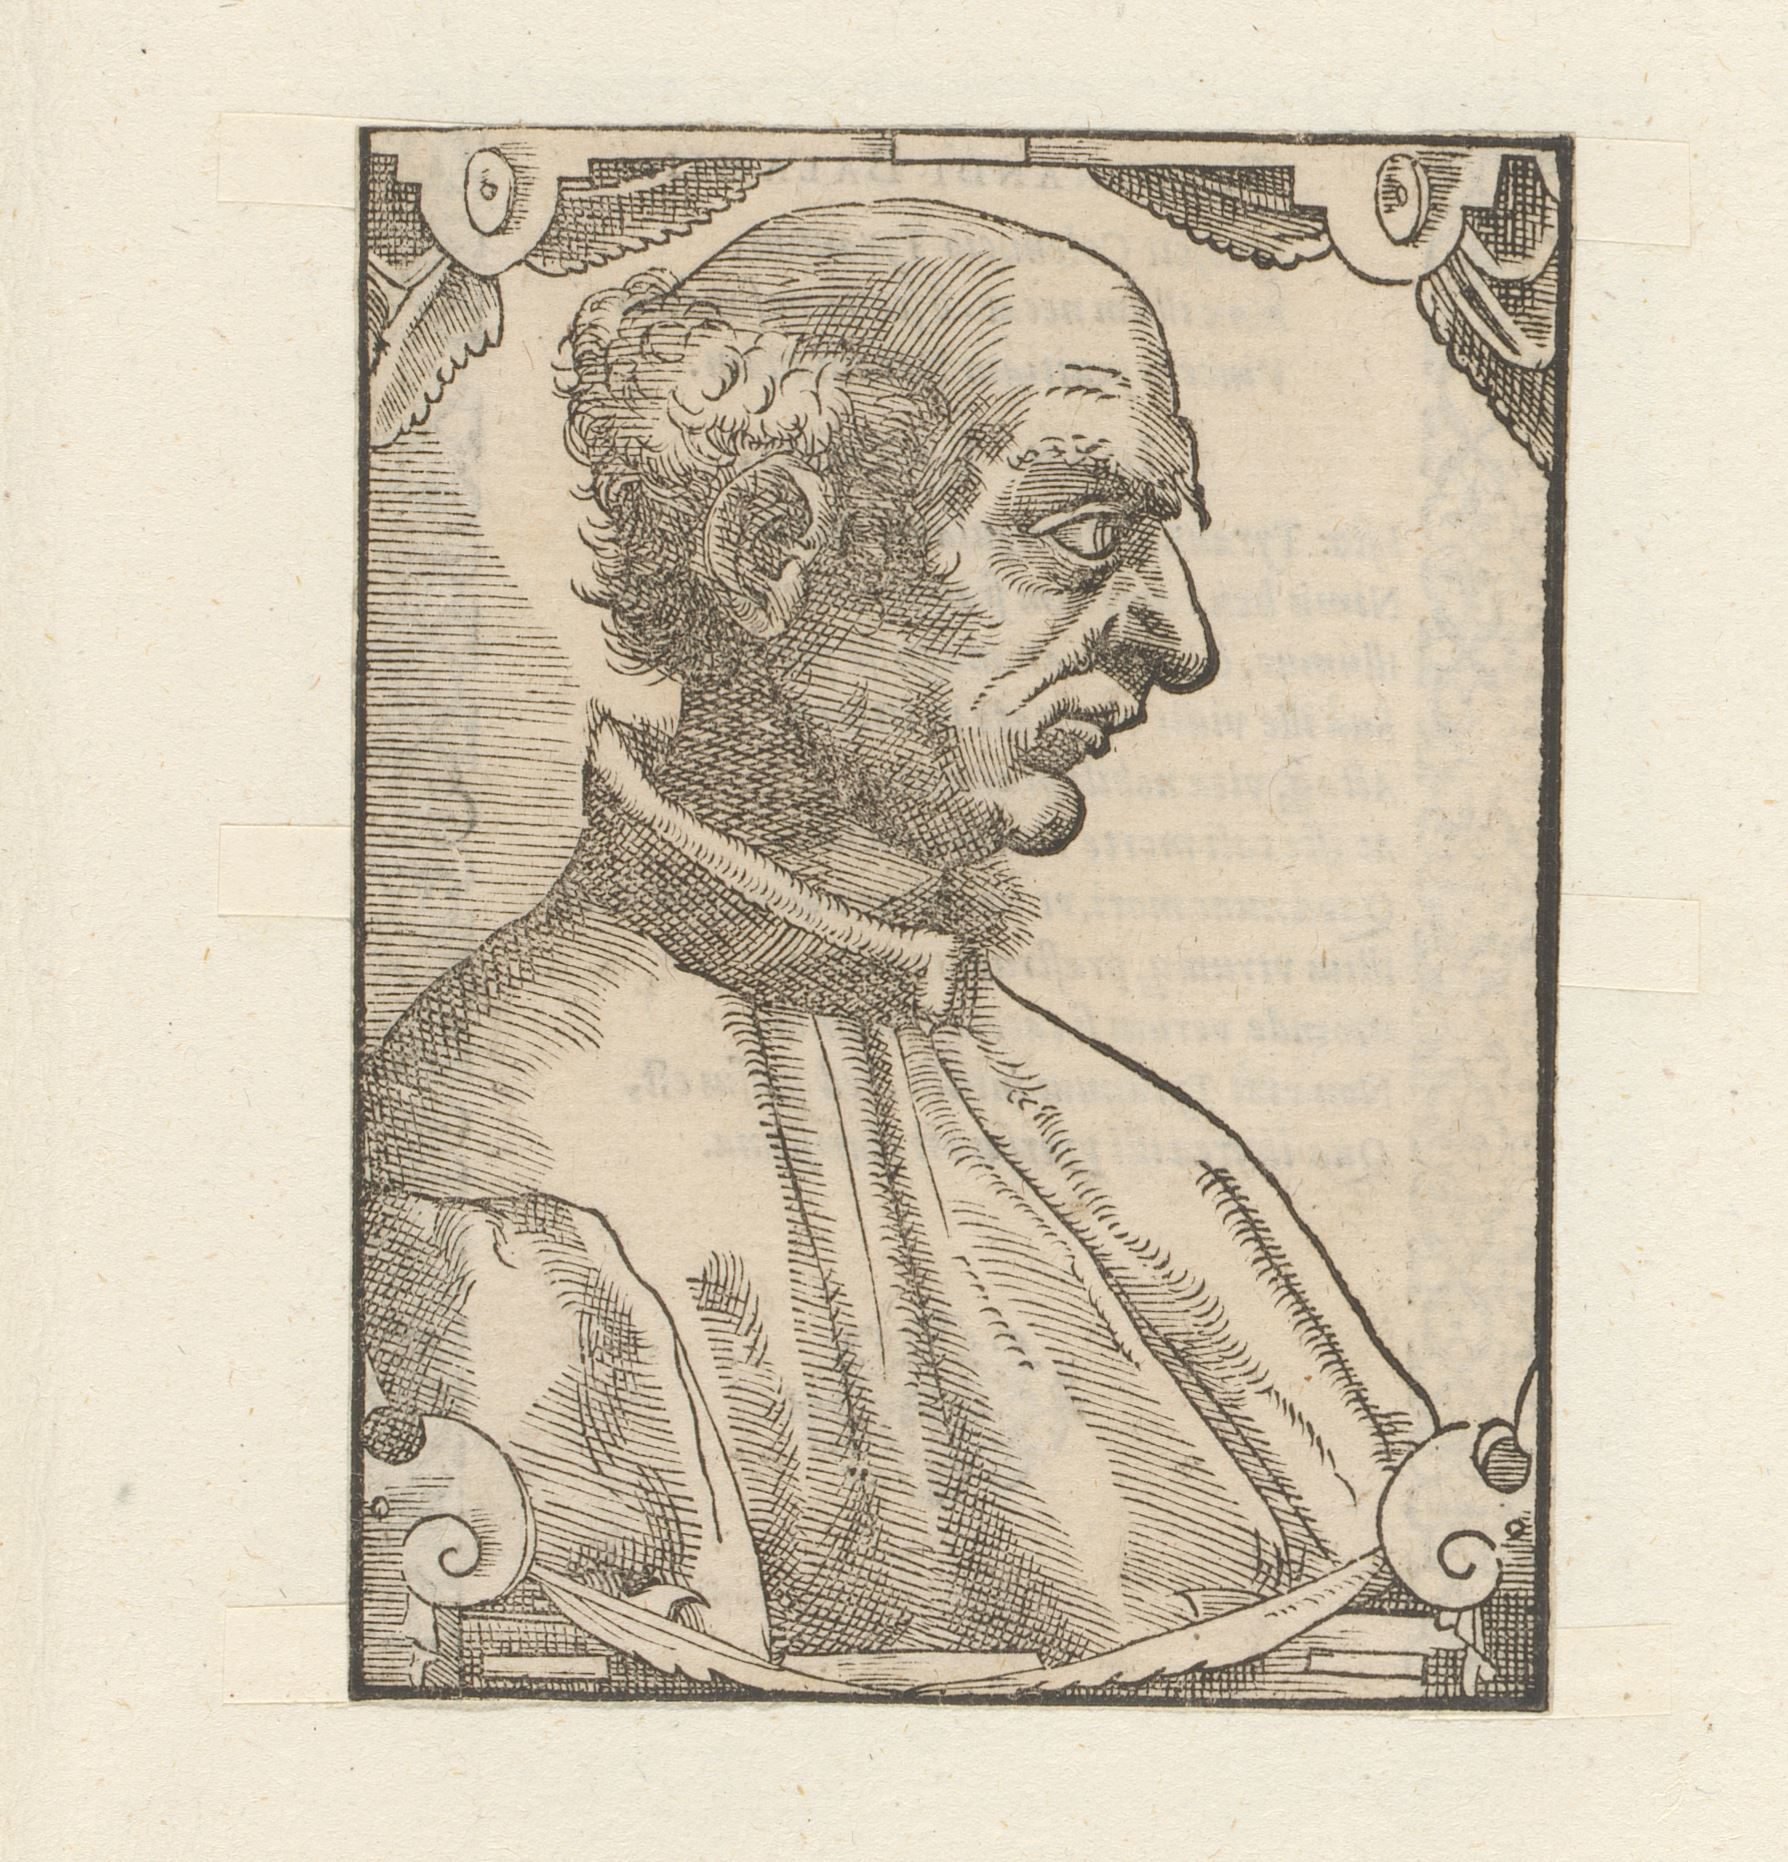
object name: print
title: Portret van Giovanni Pontano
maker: Anonymous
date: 1549-1577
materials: paper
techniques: letterpress printing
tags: naples, historical persons, writer, poet, author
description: Prent gebruikt in: Giovio, Paolo. Elogia Virorum literis illustrium (...). Bazel: Peter Perna, 1577.